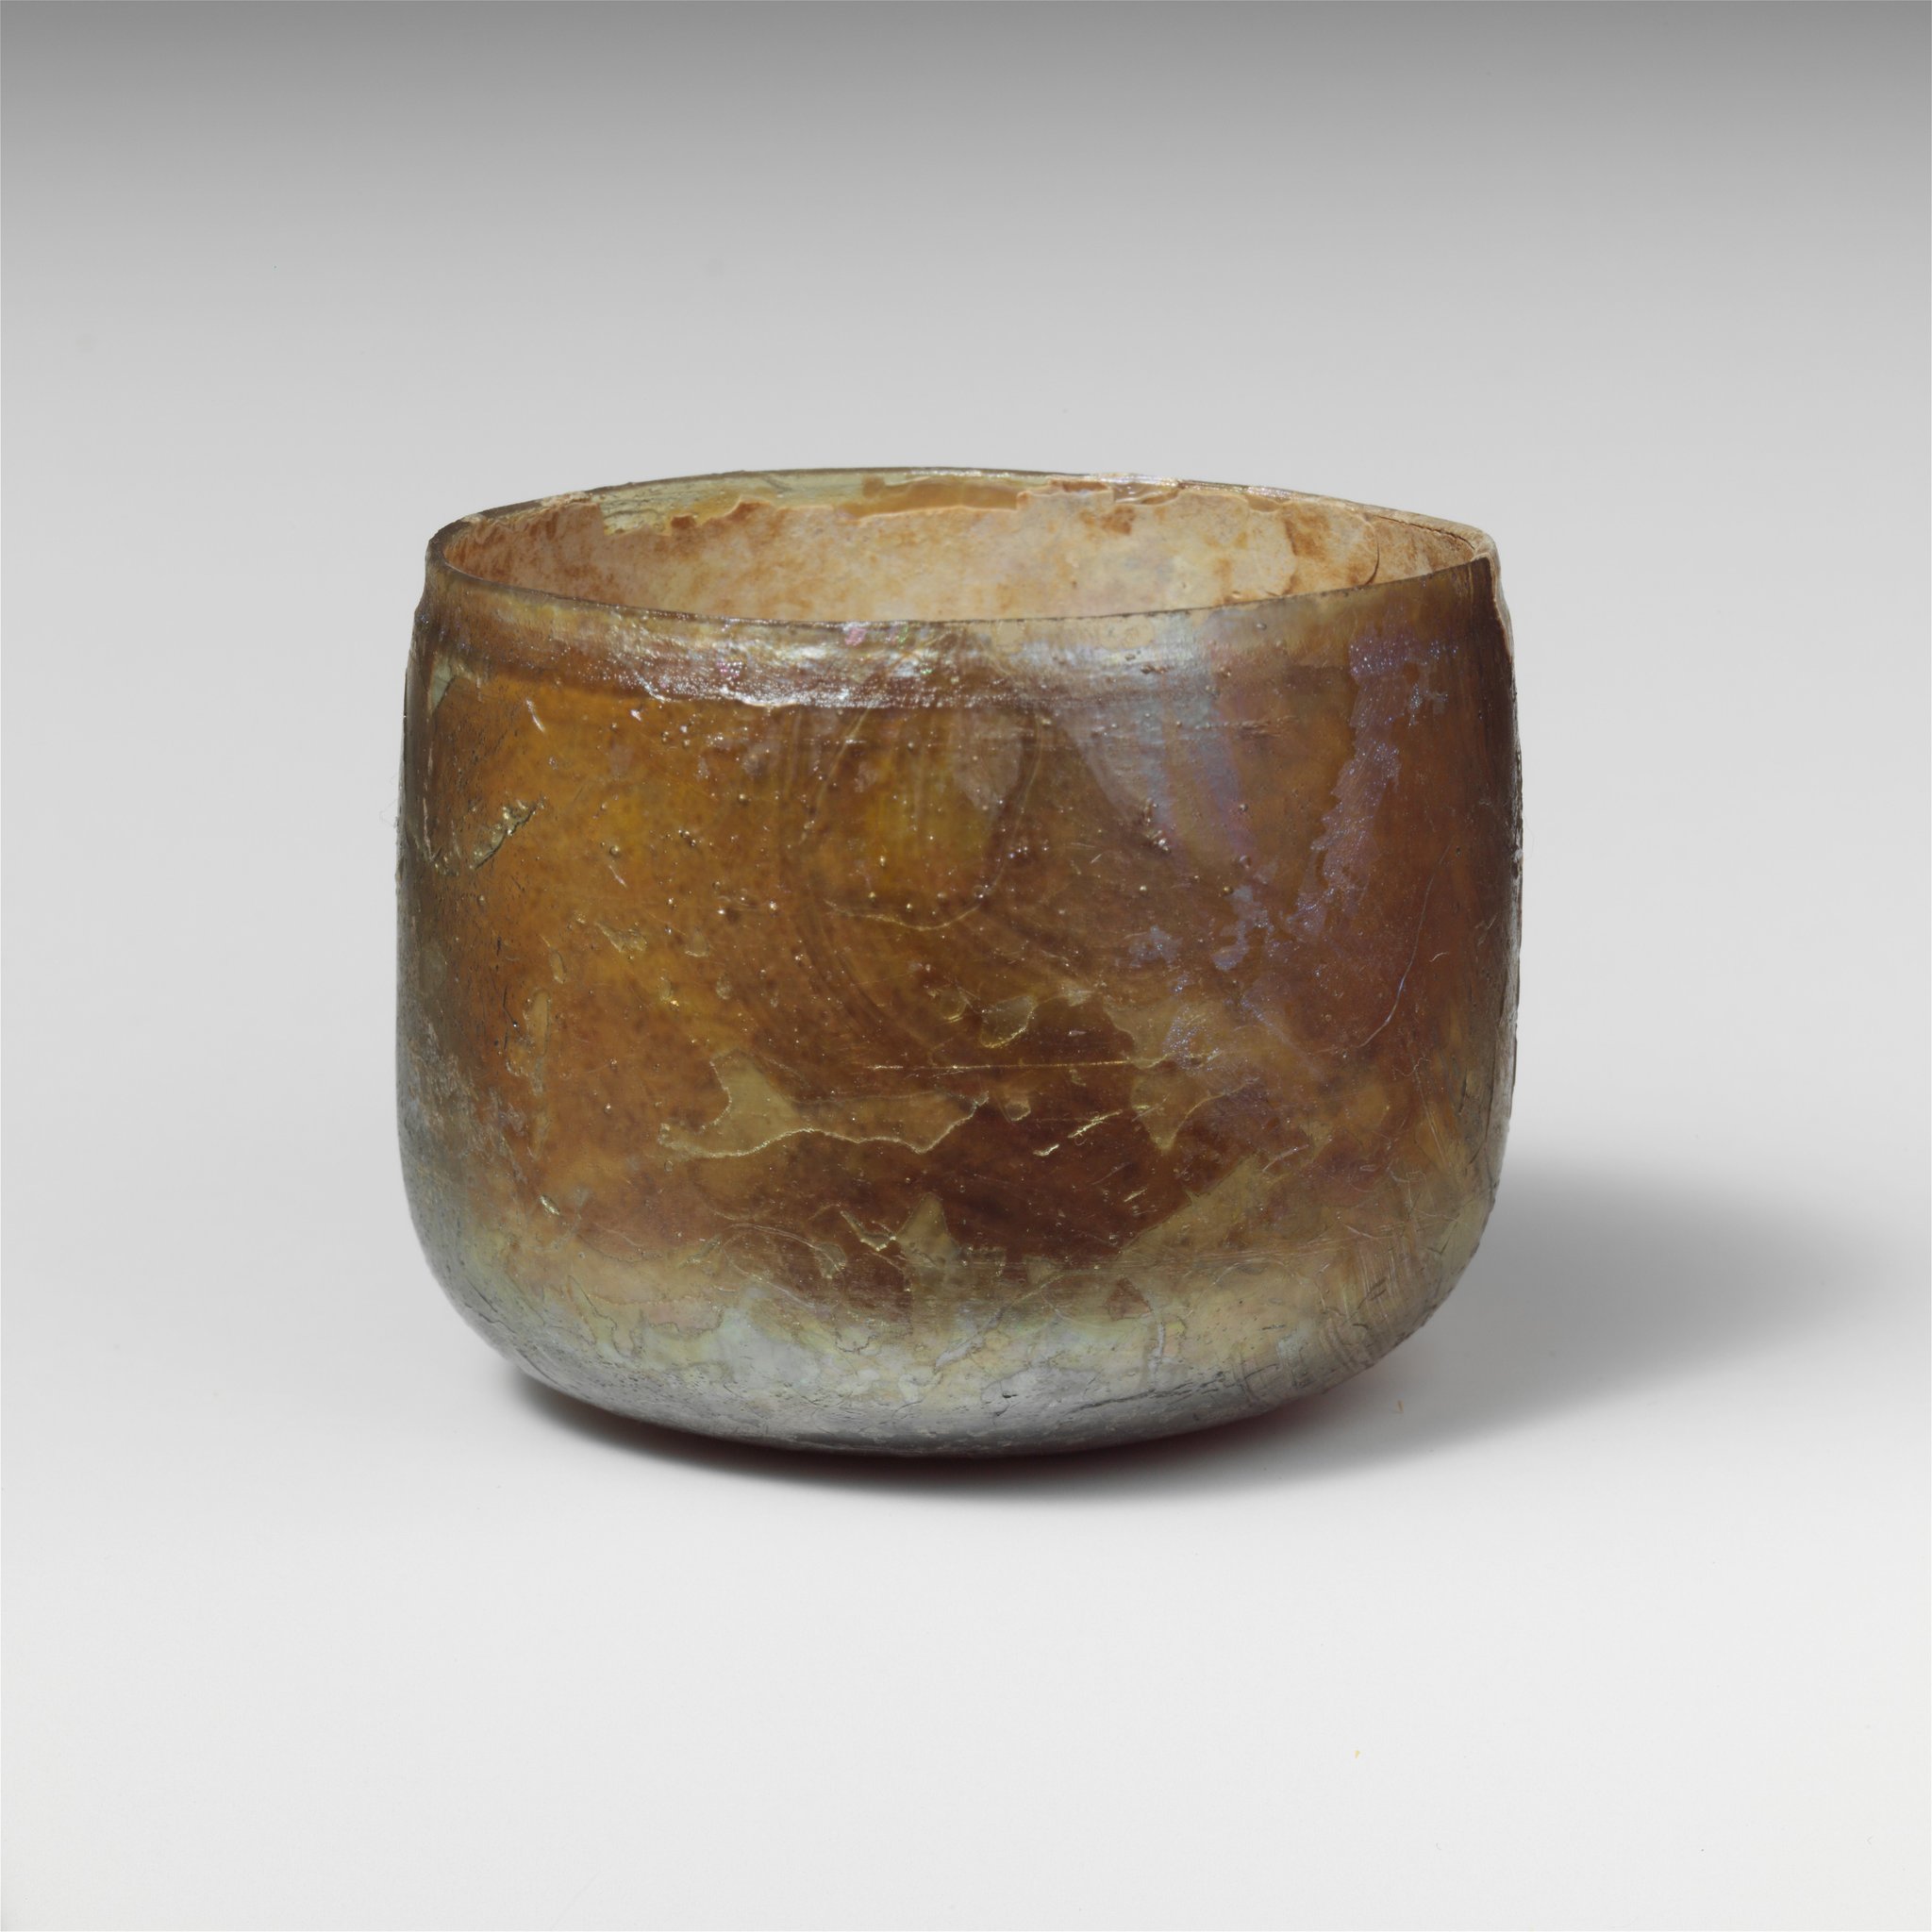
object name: cup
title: Glass cup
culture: roman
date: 1-100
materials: glass